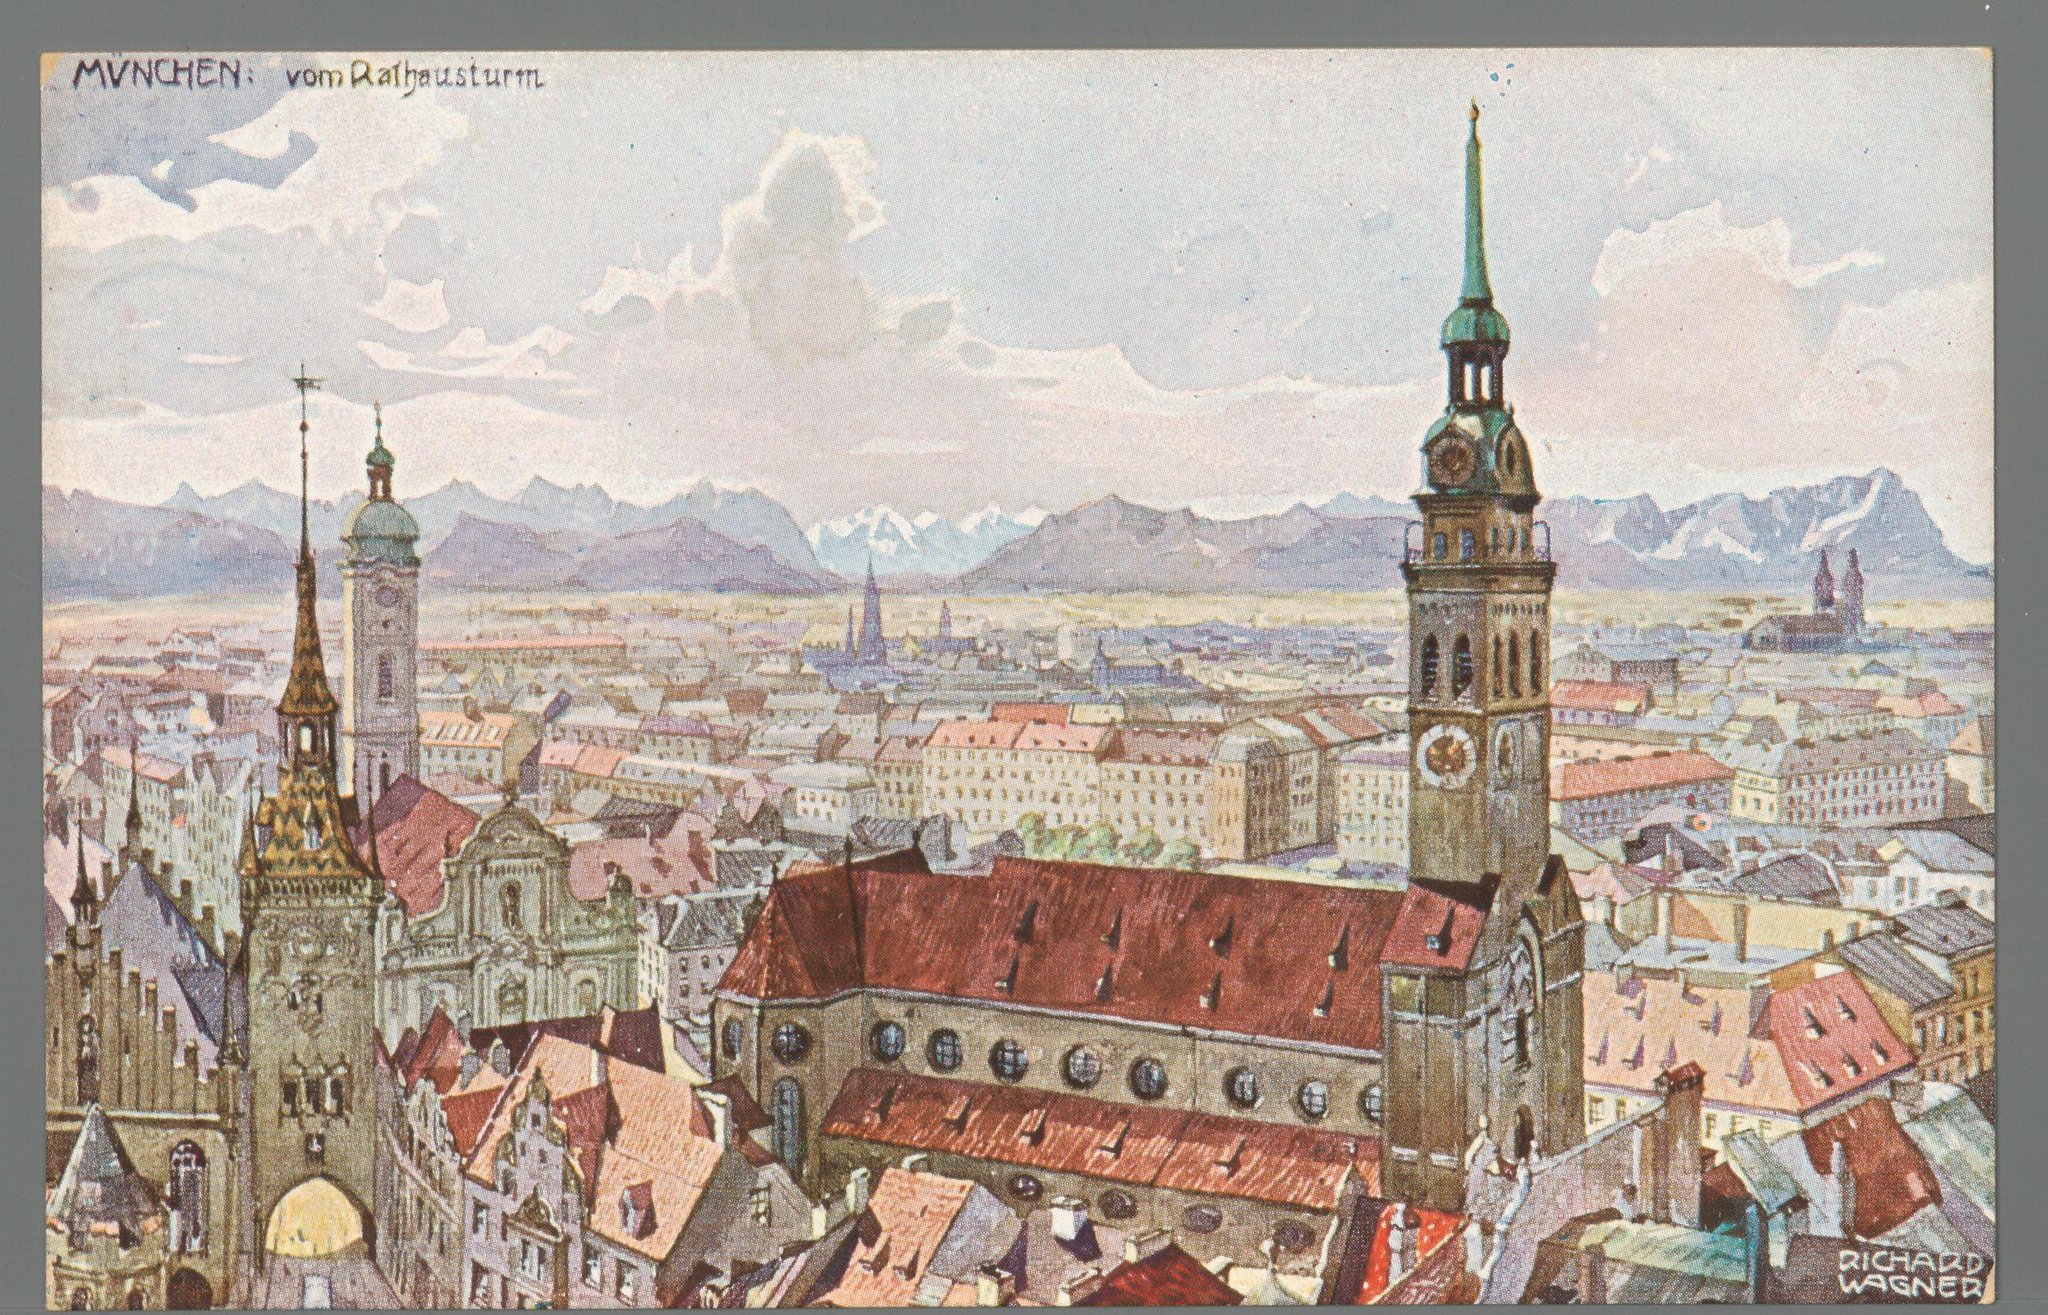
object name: ansichtkaart, prentbriefkaart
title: München: vom Rathausturm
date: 1905-1930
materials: cardboard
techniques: color autotype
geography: munich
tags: city-view, and landscape with man-made constructions, church (exterior), mountains